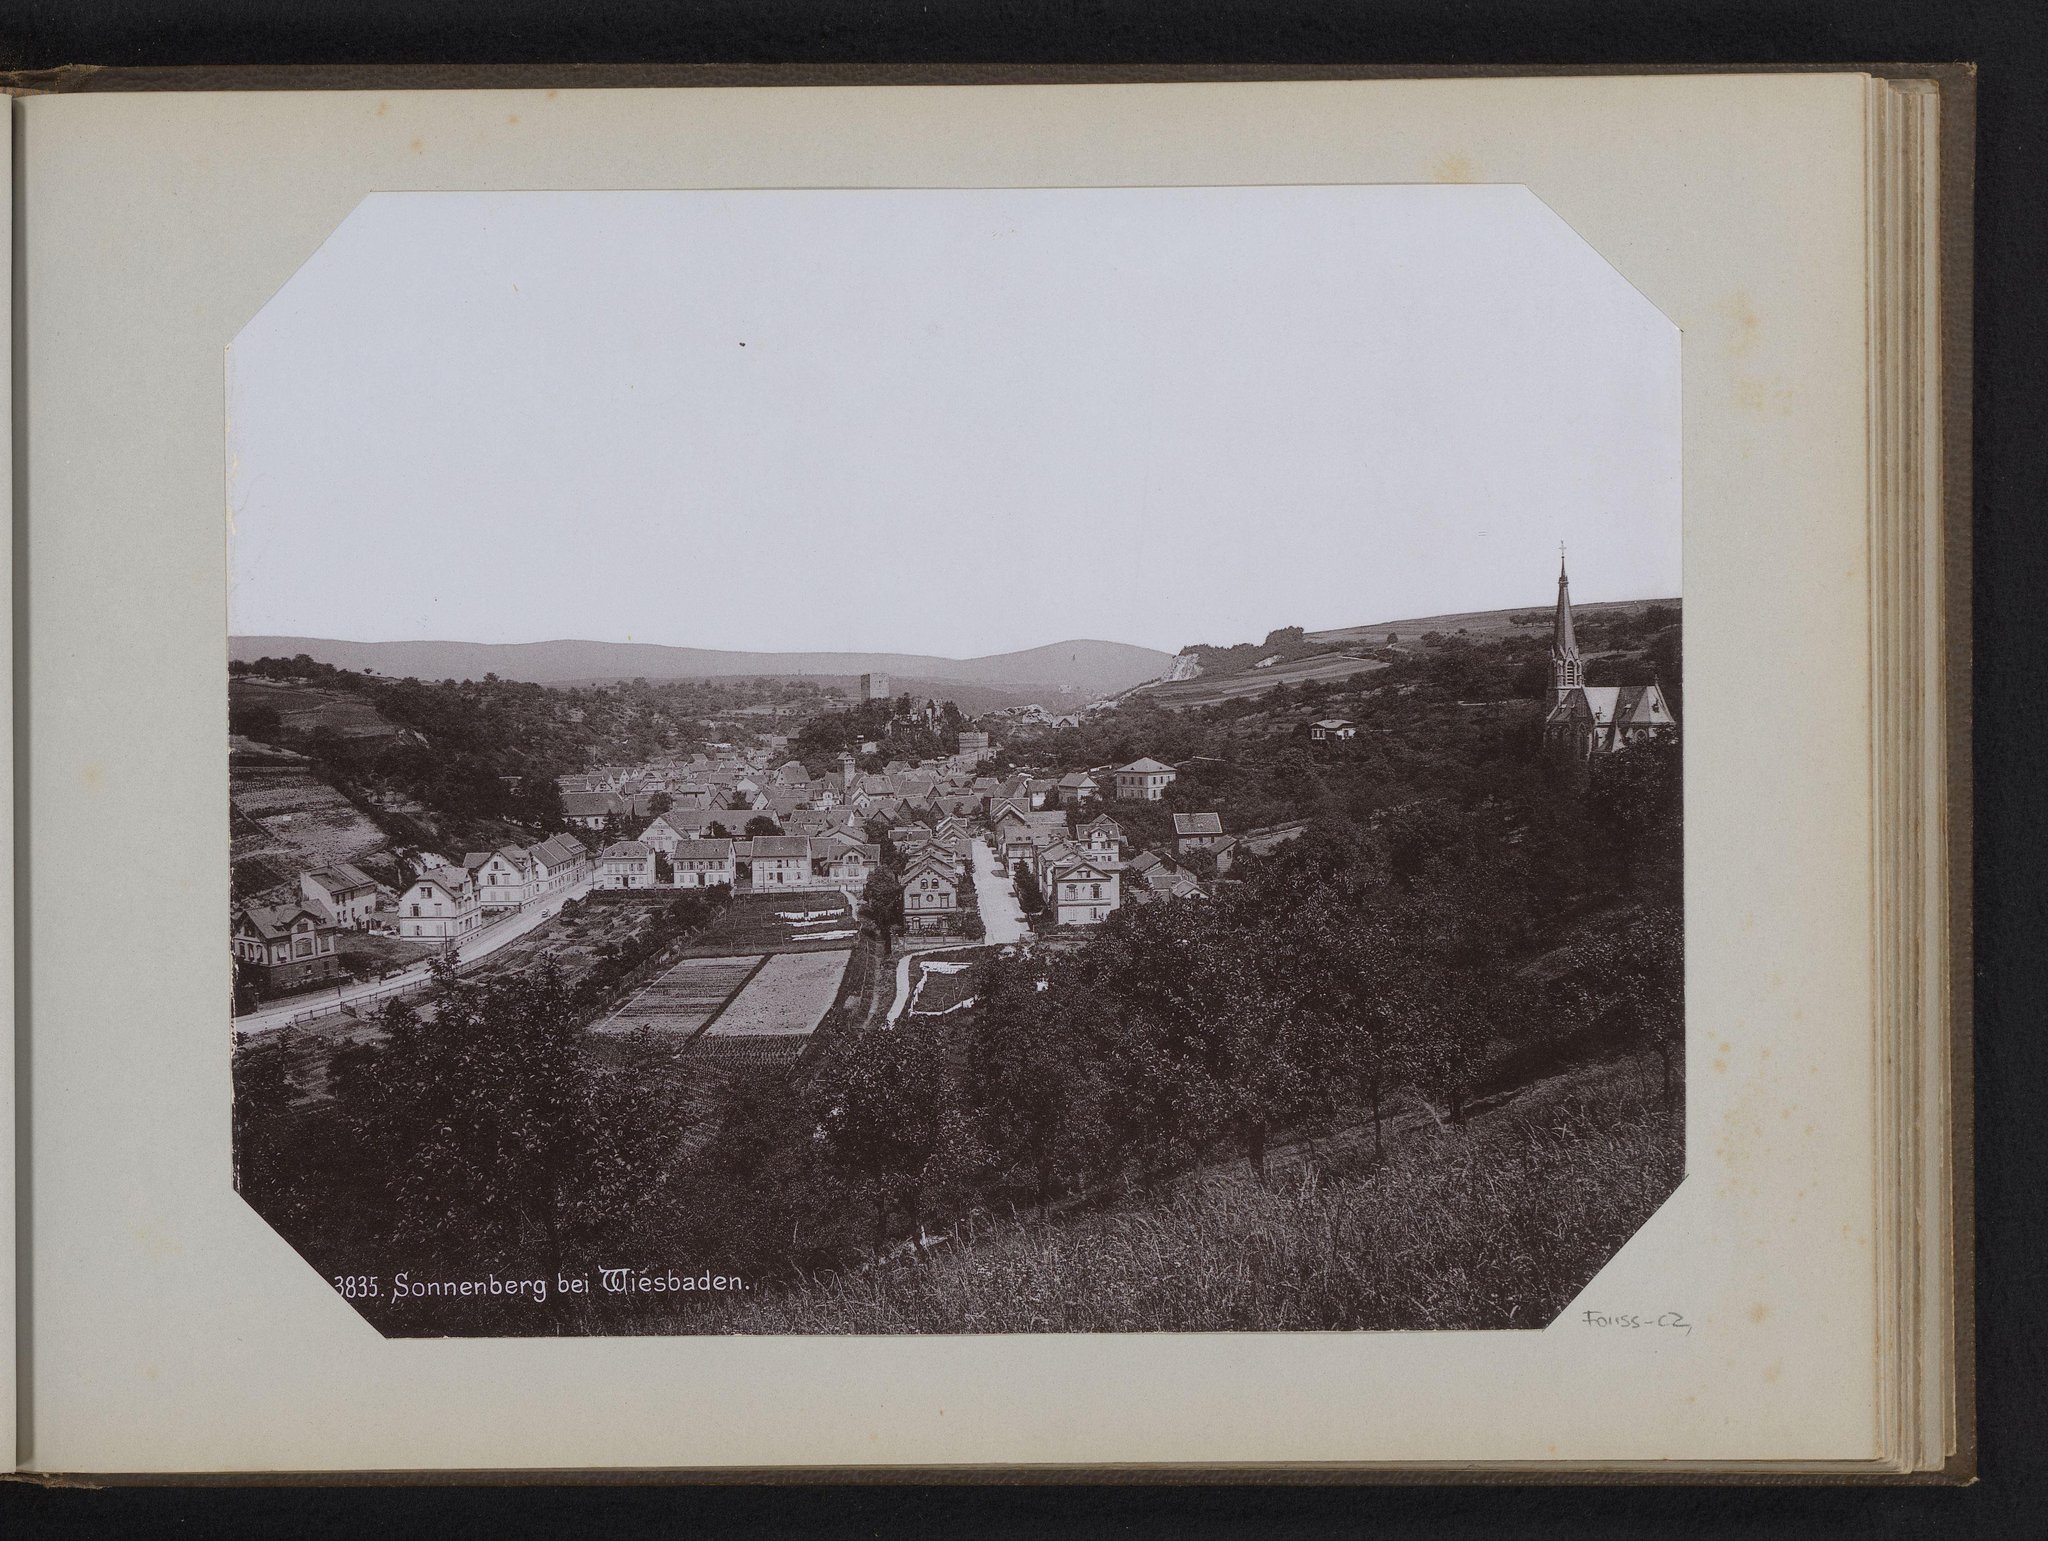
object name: album leaf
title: Gezicht op Sonnenberg bij Wiesbaden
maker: Anonymous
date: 1890-1899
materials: paper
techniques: photograph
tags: city-view in general; 'veduta', church (exterior)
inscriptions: inscription: ‘3835. Sonnenberg bei Wiesbaden.’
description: Deze prent maakt deel uit van een album.